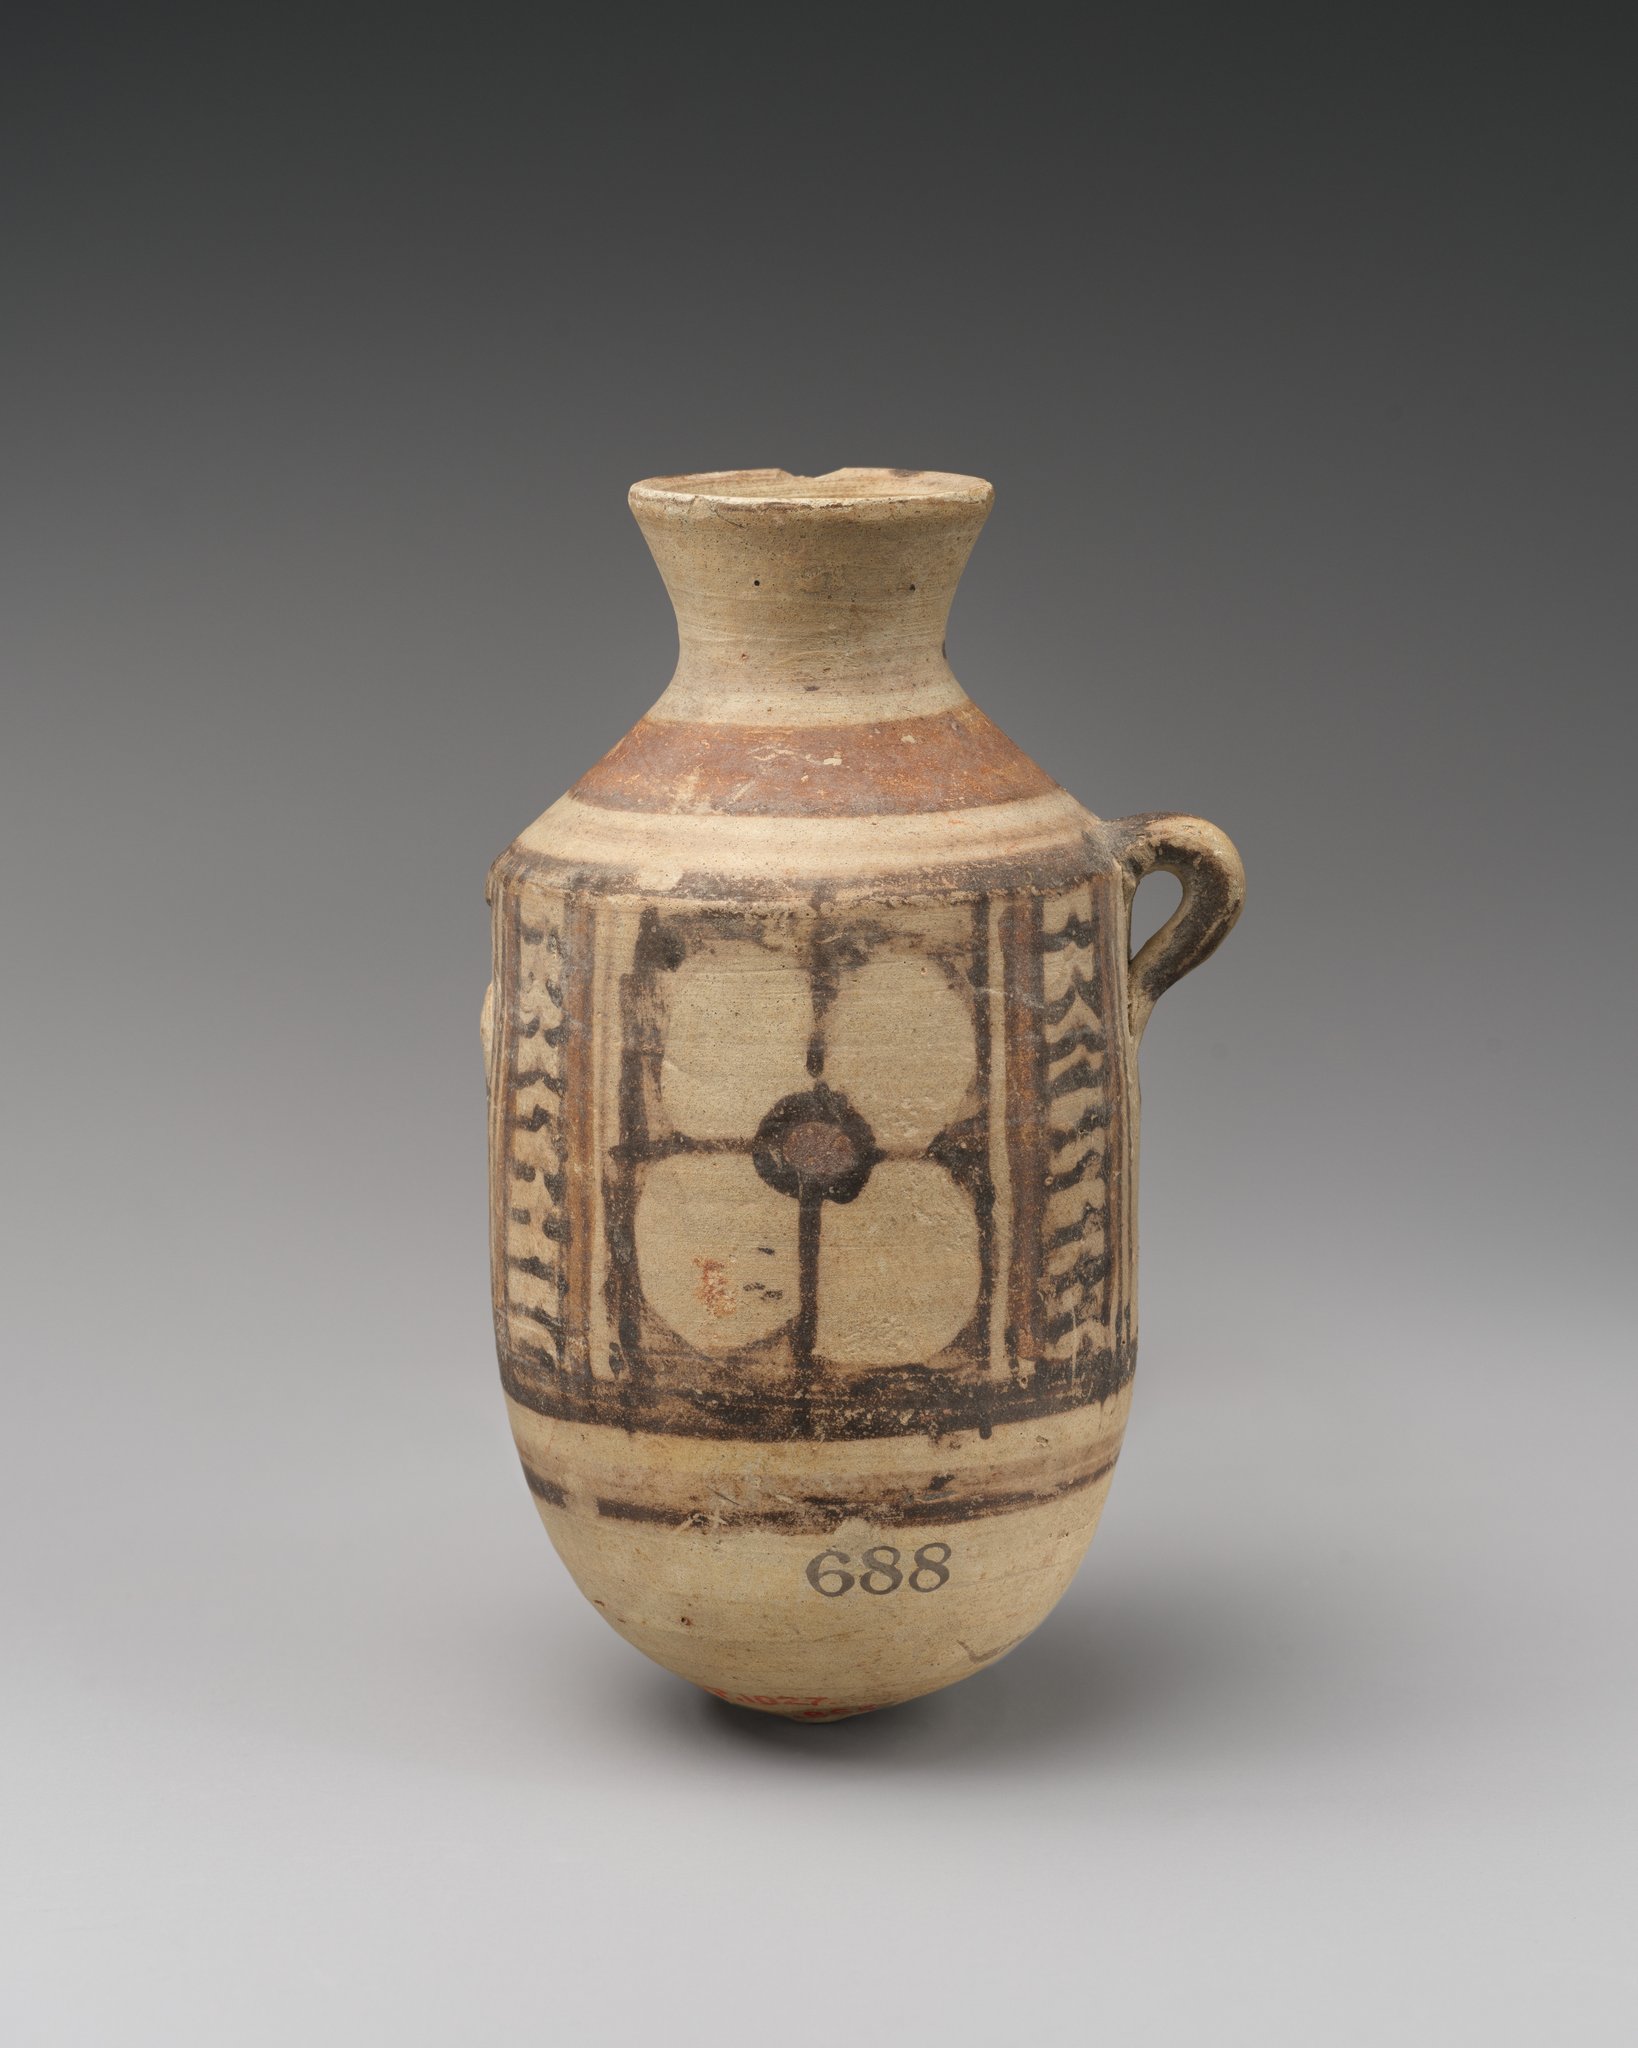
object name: flask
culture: cypriot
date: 600-480 BCE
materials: terracotta